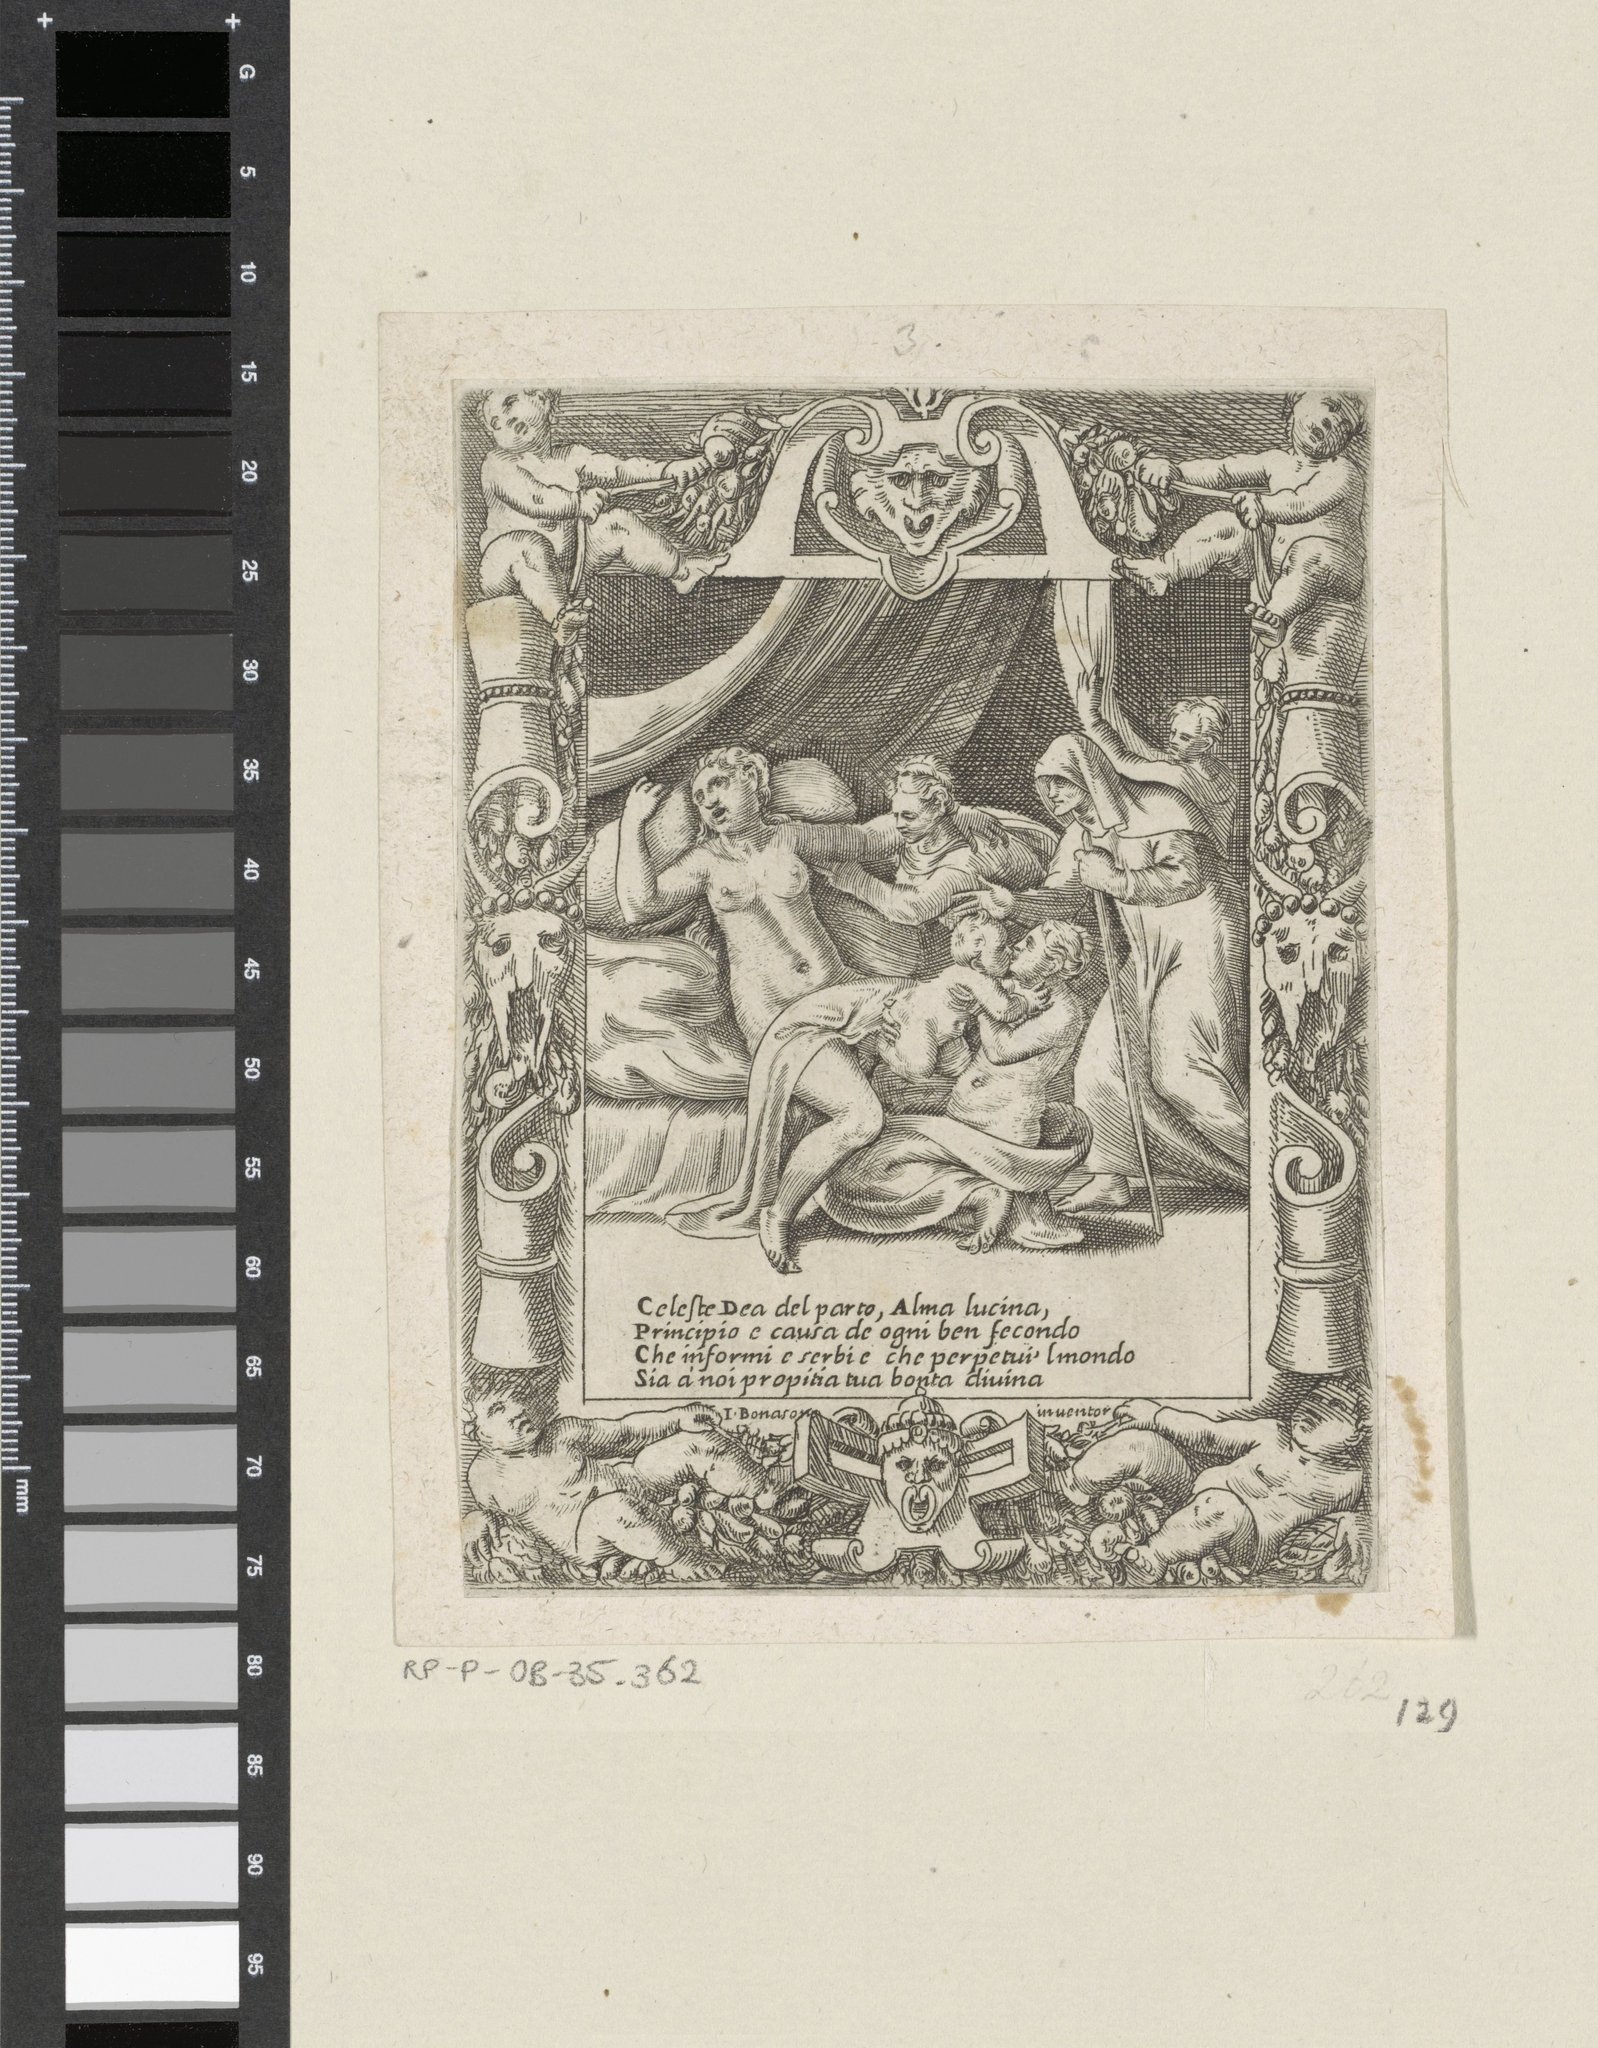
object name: print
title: Amori sdegni et gielosie di Giunone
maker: giulio bonasone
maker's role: painter, print maker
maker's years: 1510-1576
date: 1501-1580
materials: paper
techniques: engraving, etching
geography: italy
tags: juno lucina, goddess of childbirth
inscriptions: collector's mark: Lugt 240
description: Een bevallende vrouw op een bed. Ze wordt vastgehouden door een vrouw. Een andere vrouw zit tussen haar benen en houdt een baby vast. De bevallende vrouw roept om de hulp van Juno Lucina (godin van de geboorte). Onder een vierregelig vers in het Italiaans. De voorstelling is gevat in een sierlijst met putti en schedels.